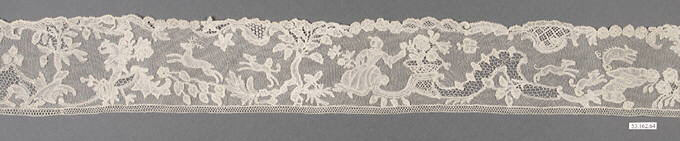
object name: border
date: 1701-1800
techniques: lace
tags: human figures,deer